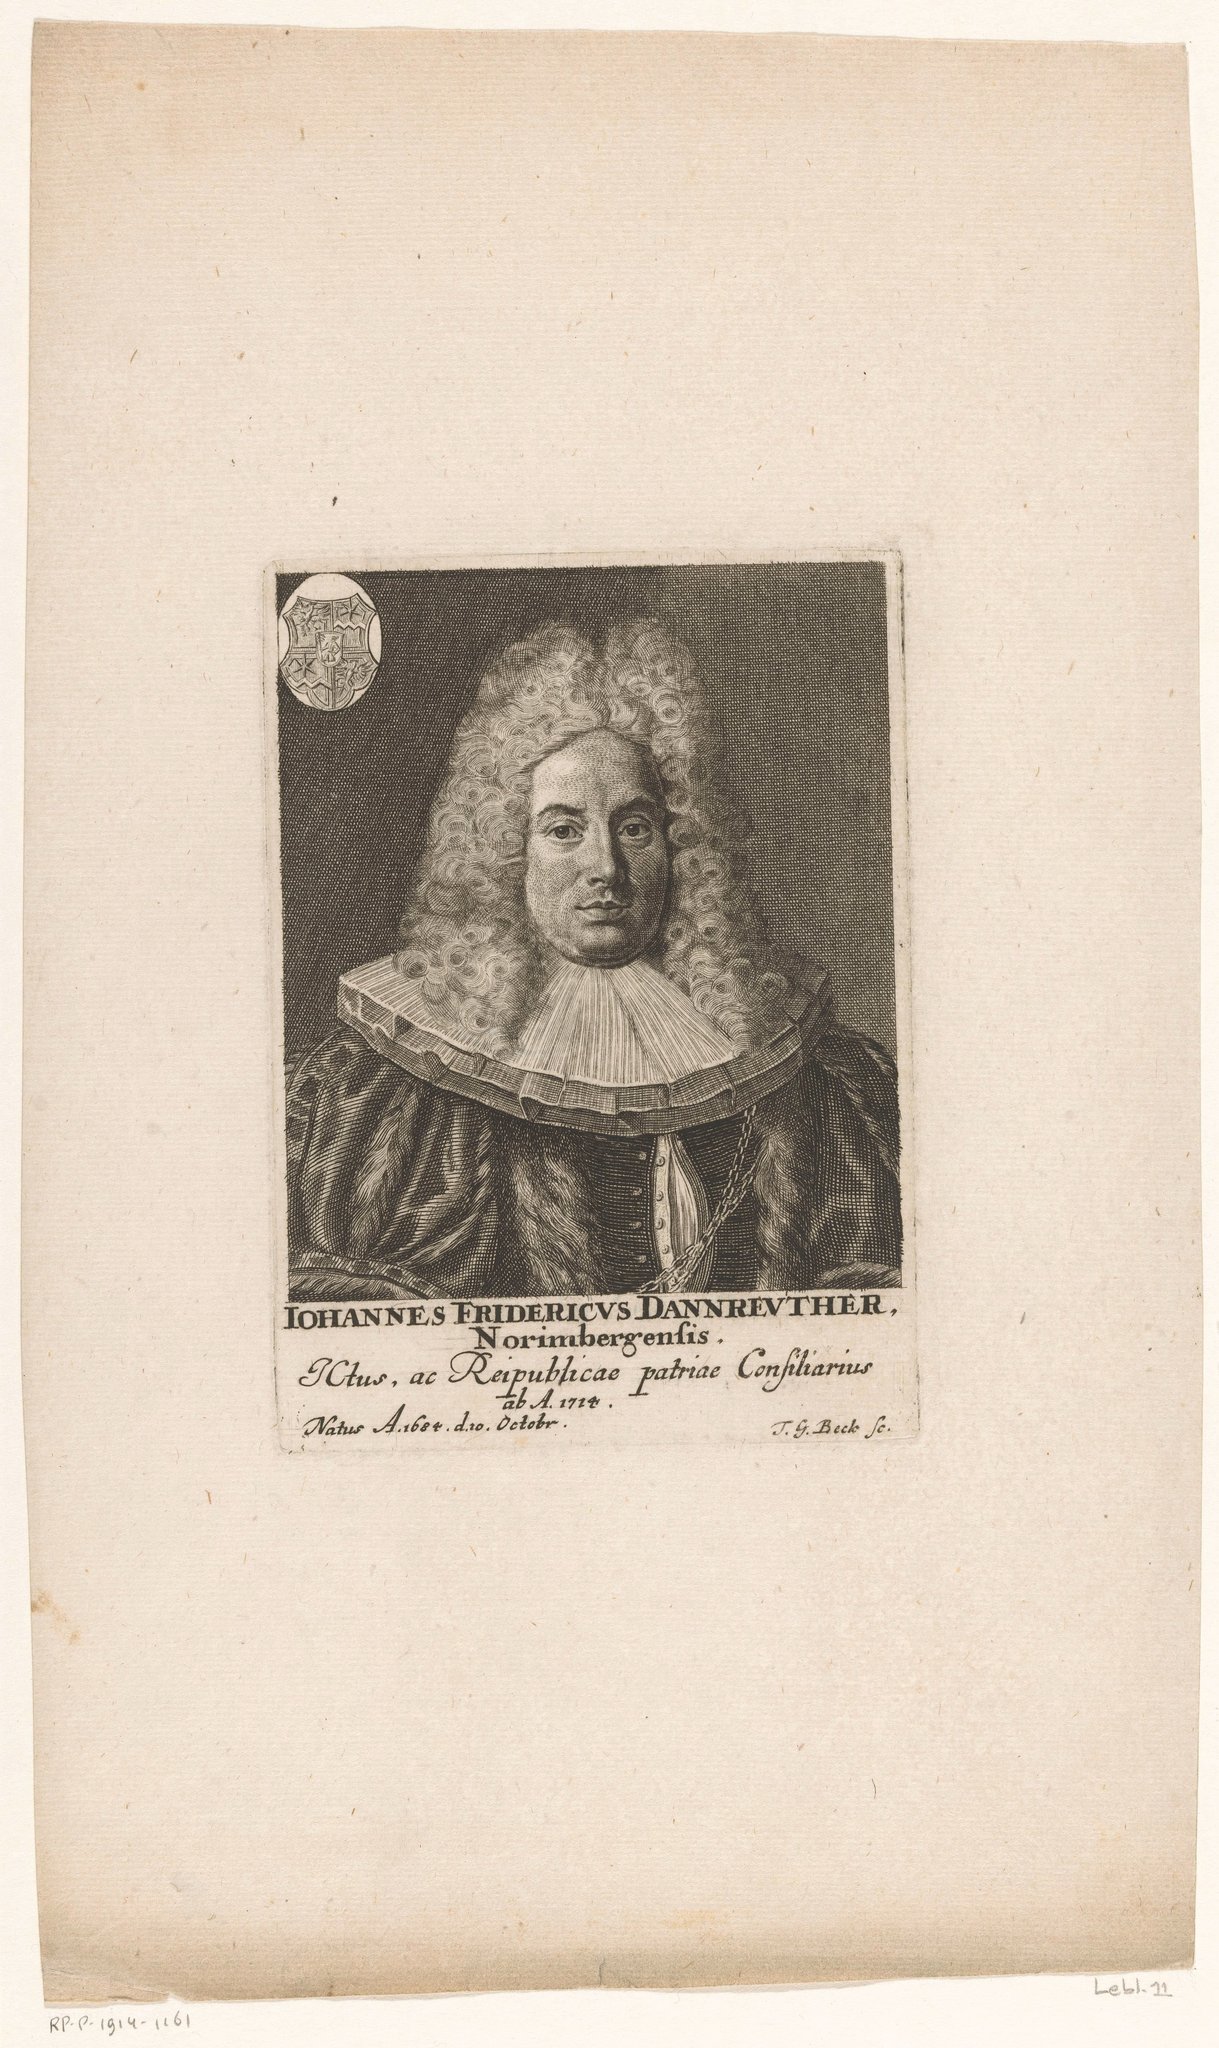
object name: print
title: Portret van Johann Friedrich Dannreuther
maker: tobias gabriel beck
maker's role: print maker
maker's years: 1685-1755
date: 1714-1755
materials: paper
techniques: engraving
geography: nuremberg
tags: historical persons, armorial bearing, heraldry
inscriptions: collector's mark: Lugt 2228